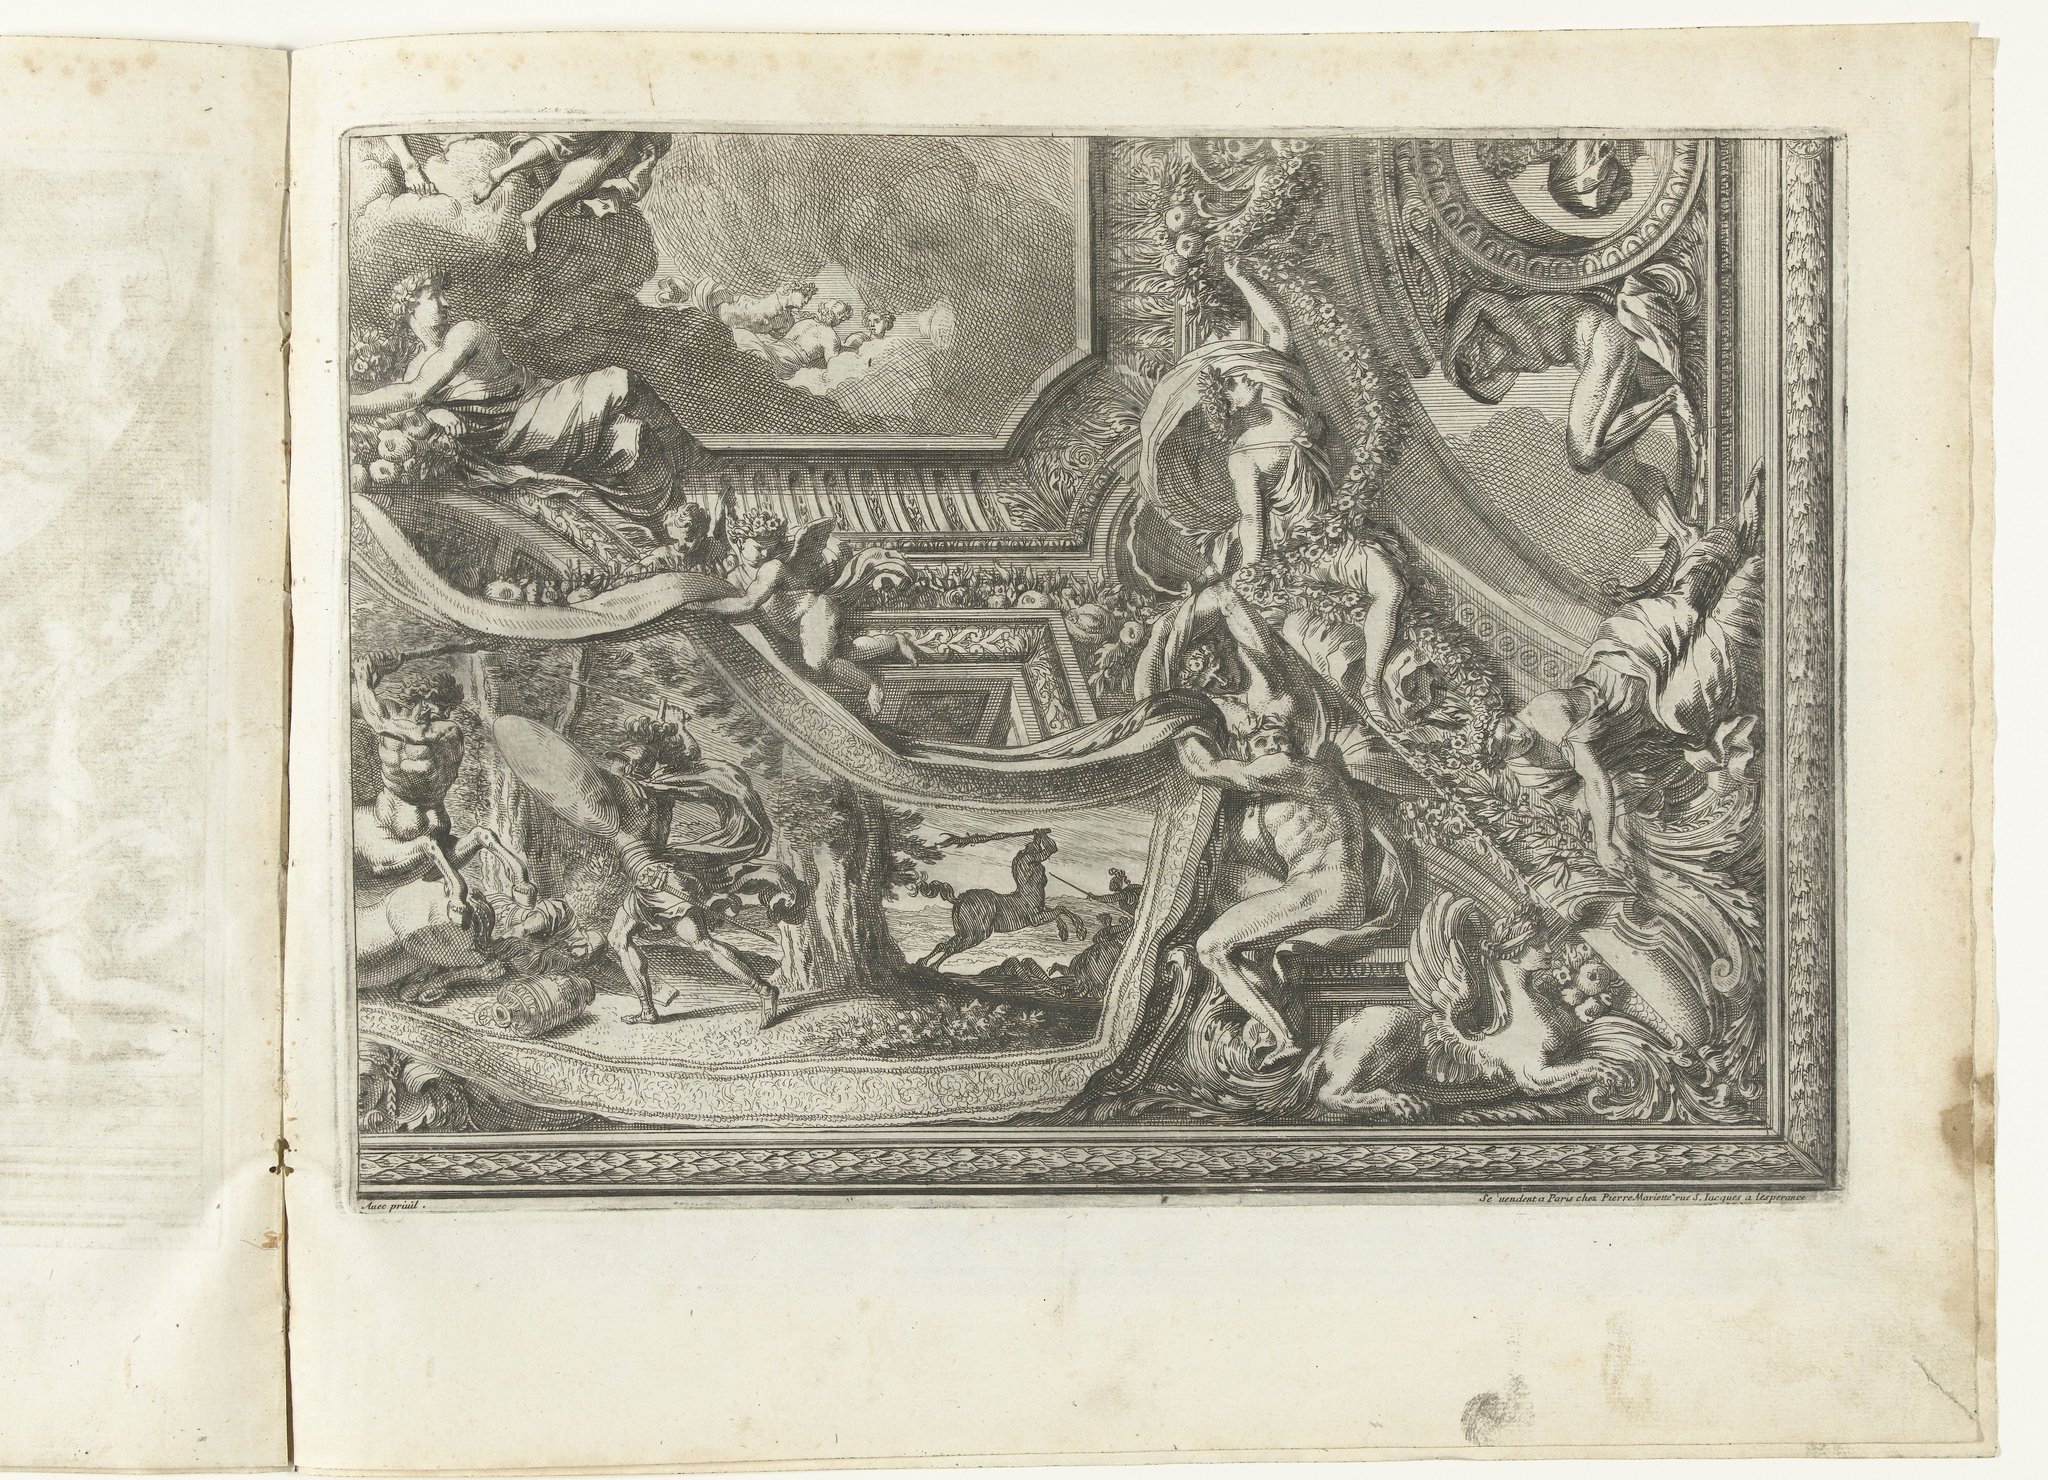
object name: print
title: Plafond met cartouche in vorm van wandtapijt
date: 1661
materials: paper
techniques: etching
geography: france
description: Op de cartouche strijdt een Lapith tegen een Centaur. Plafond met varianten voor twee kwart gedeeltes van de rand. Blad uit serie van 6 bladen met grote kwarten van plafonds in klassieke stijl, sommige met varianten voor de randen. Uit eerste editie.